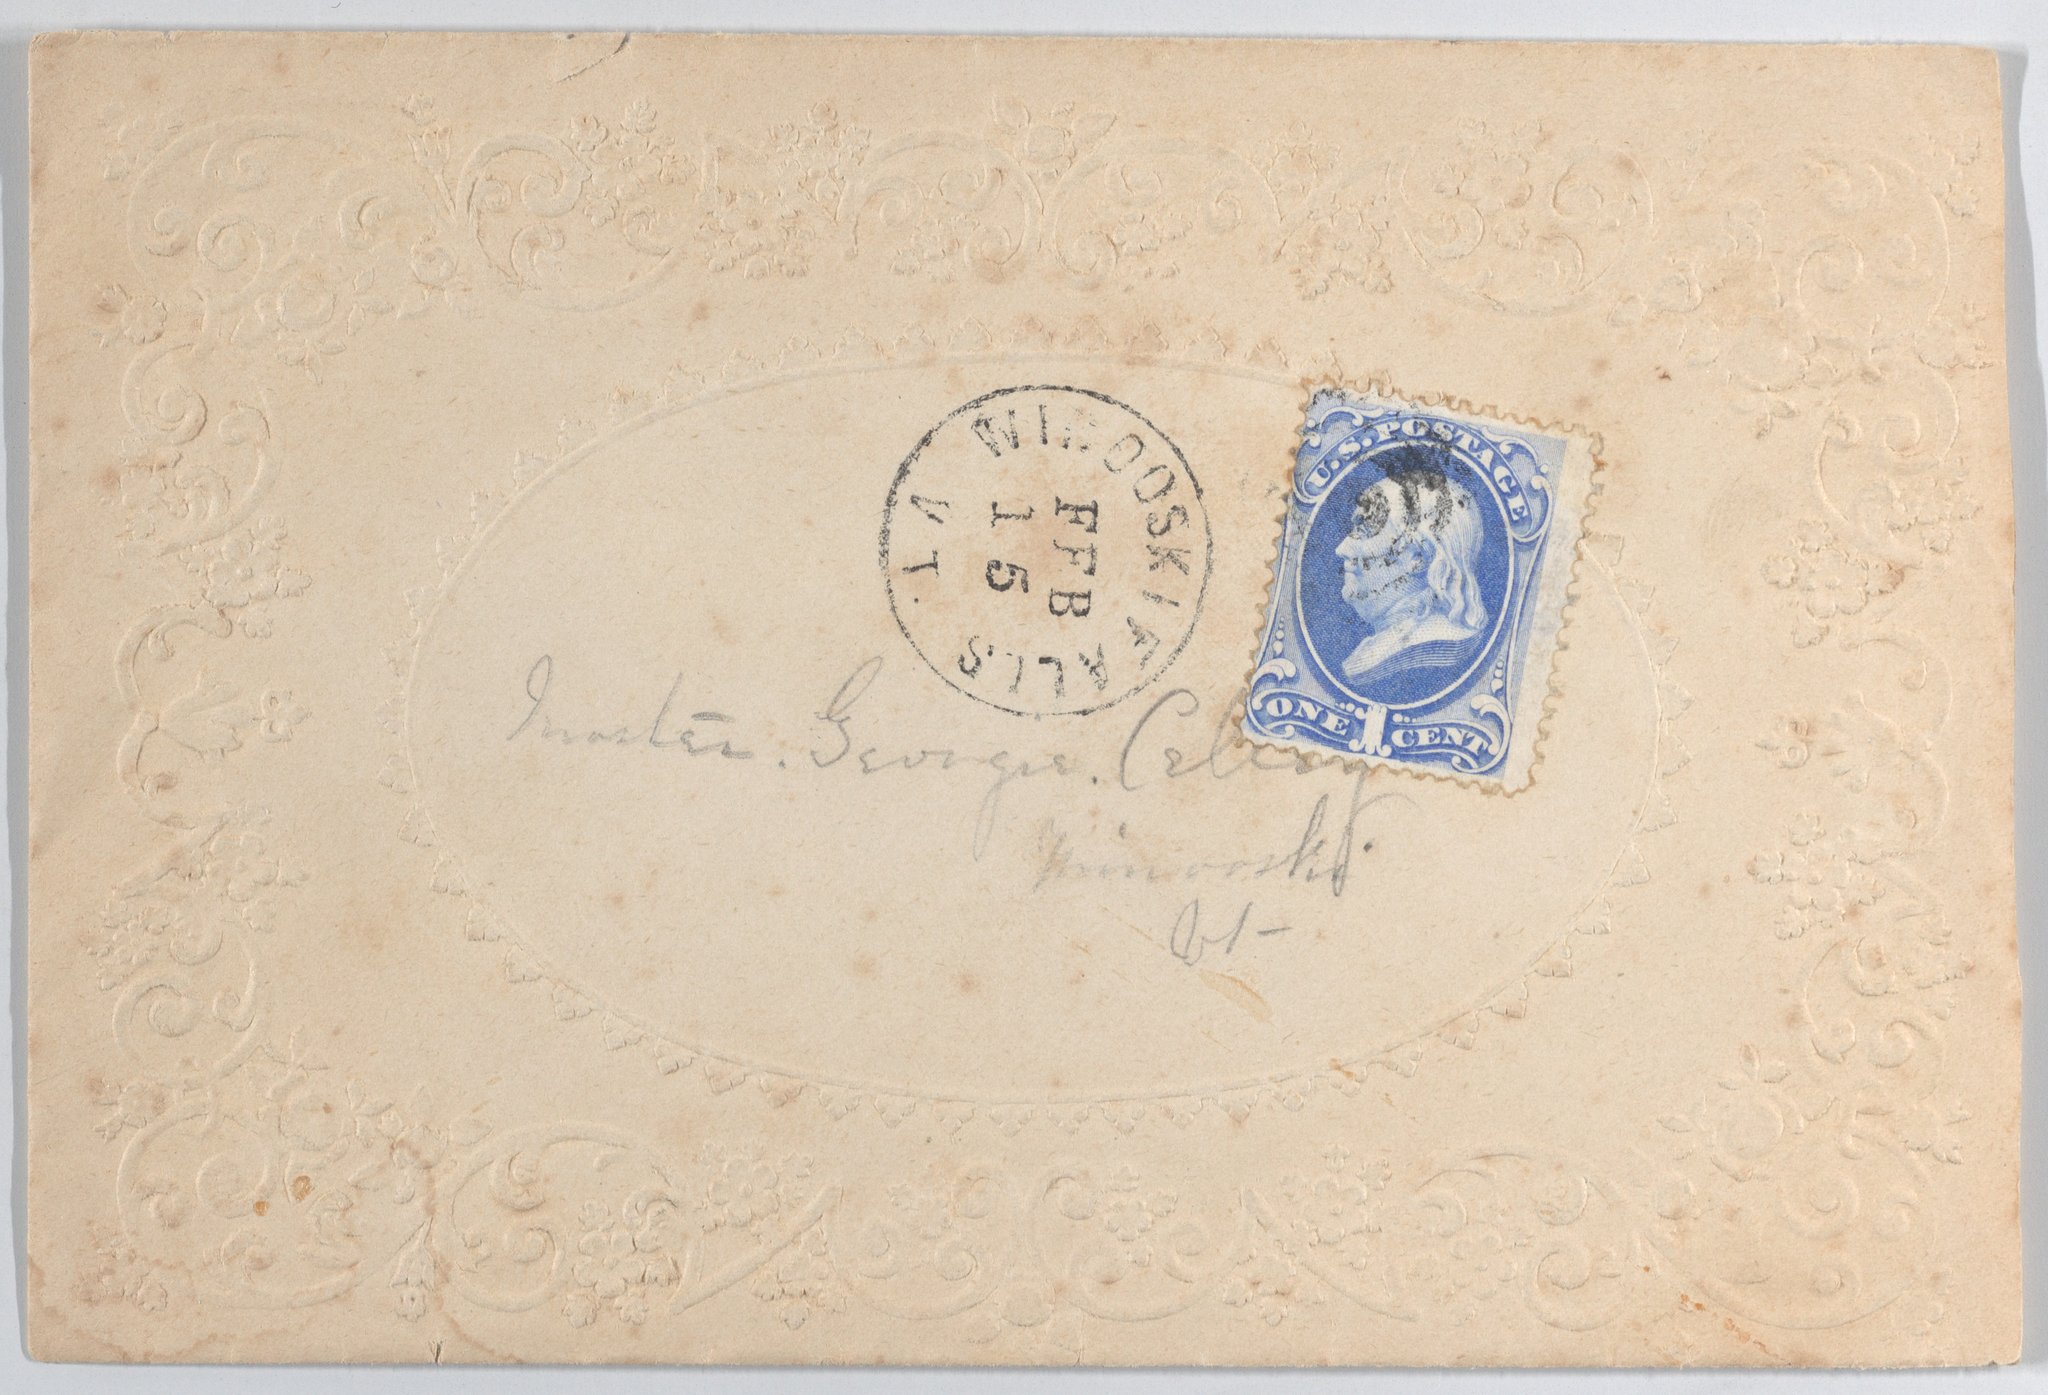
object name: valentine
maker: Anonymous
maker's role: artist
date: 1870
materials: graphite, lace, paper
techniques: chromolithography, embossing, open work